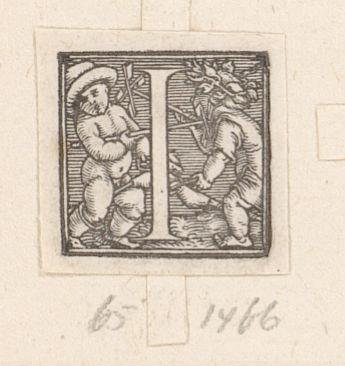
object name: print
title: Latijns alfabet met kinderen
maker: hans lützelburger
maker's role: print maker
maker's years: -1526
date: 1522-1526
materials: paper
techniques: woodcut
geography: basel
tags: initial, cupids: 'amores', 'amoretti', 'putti'